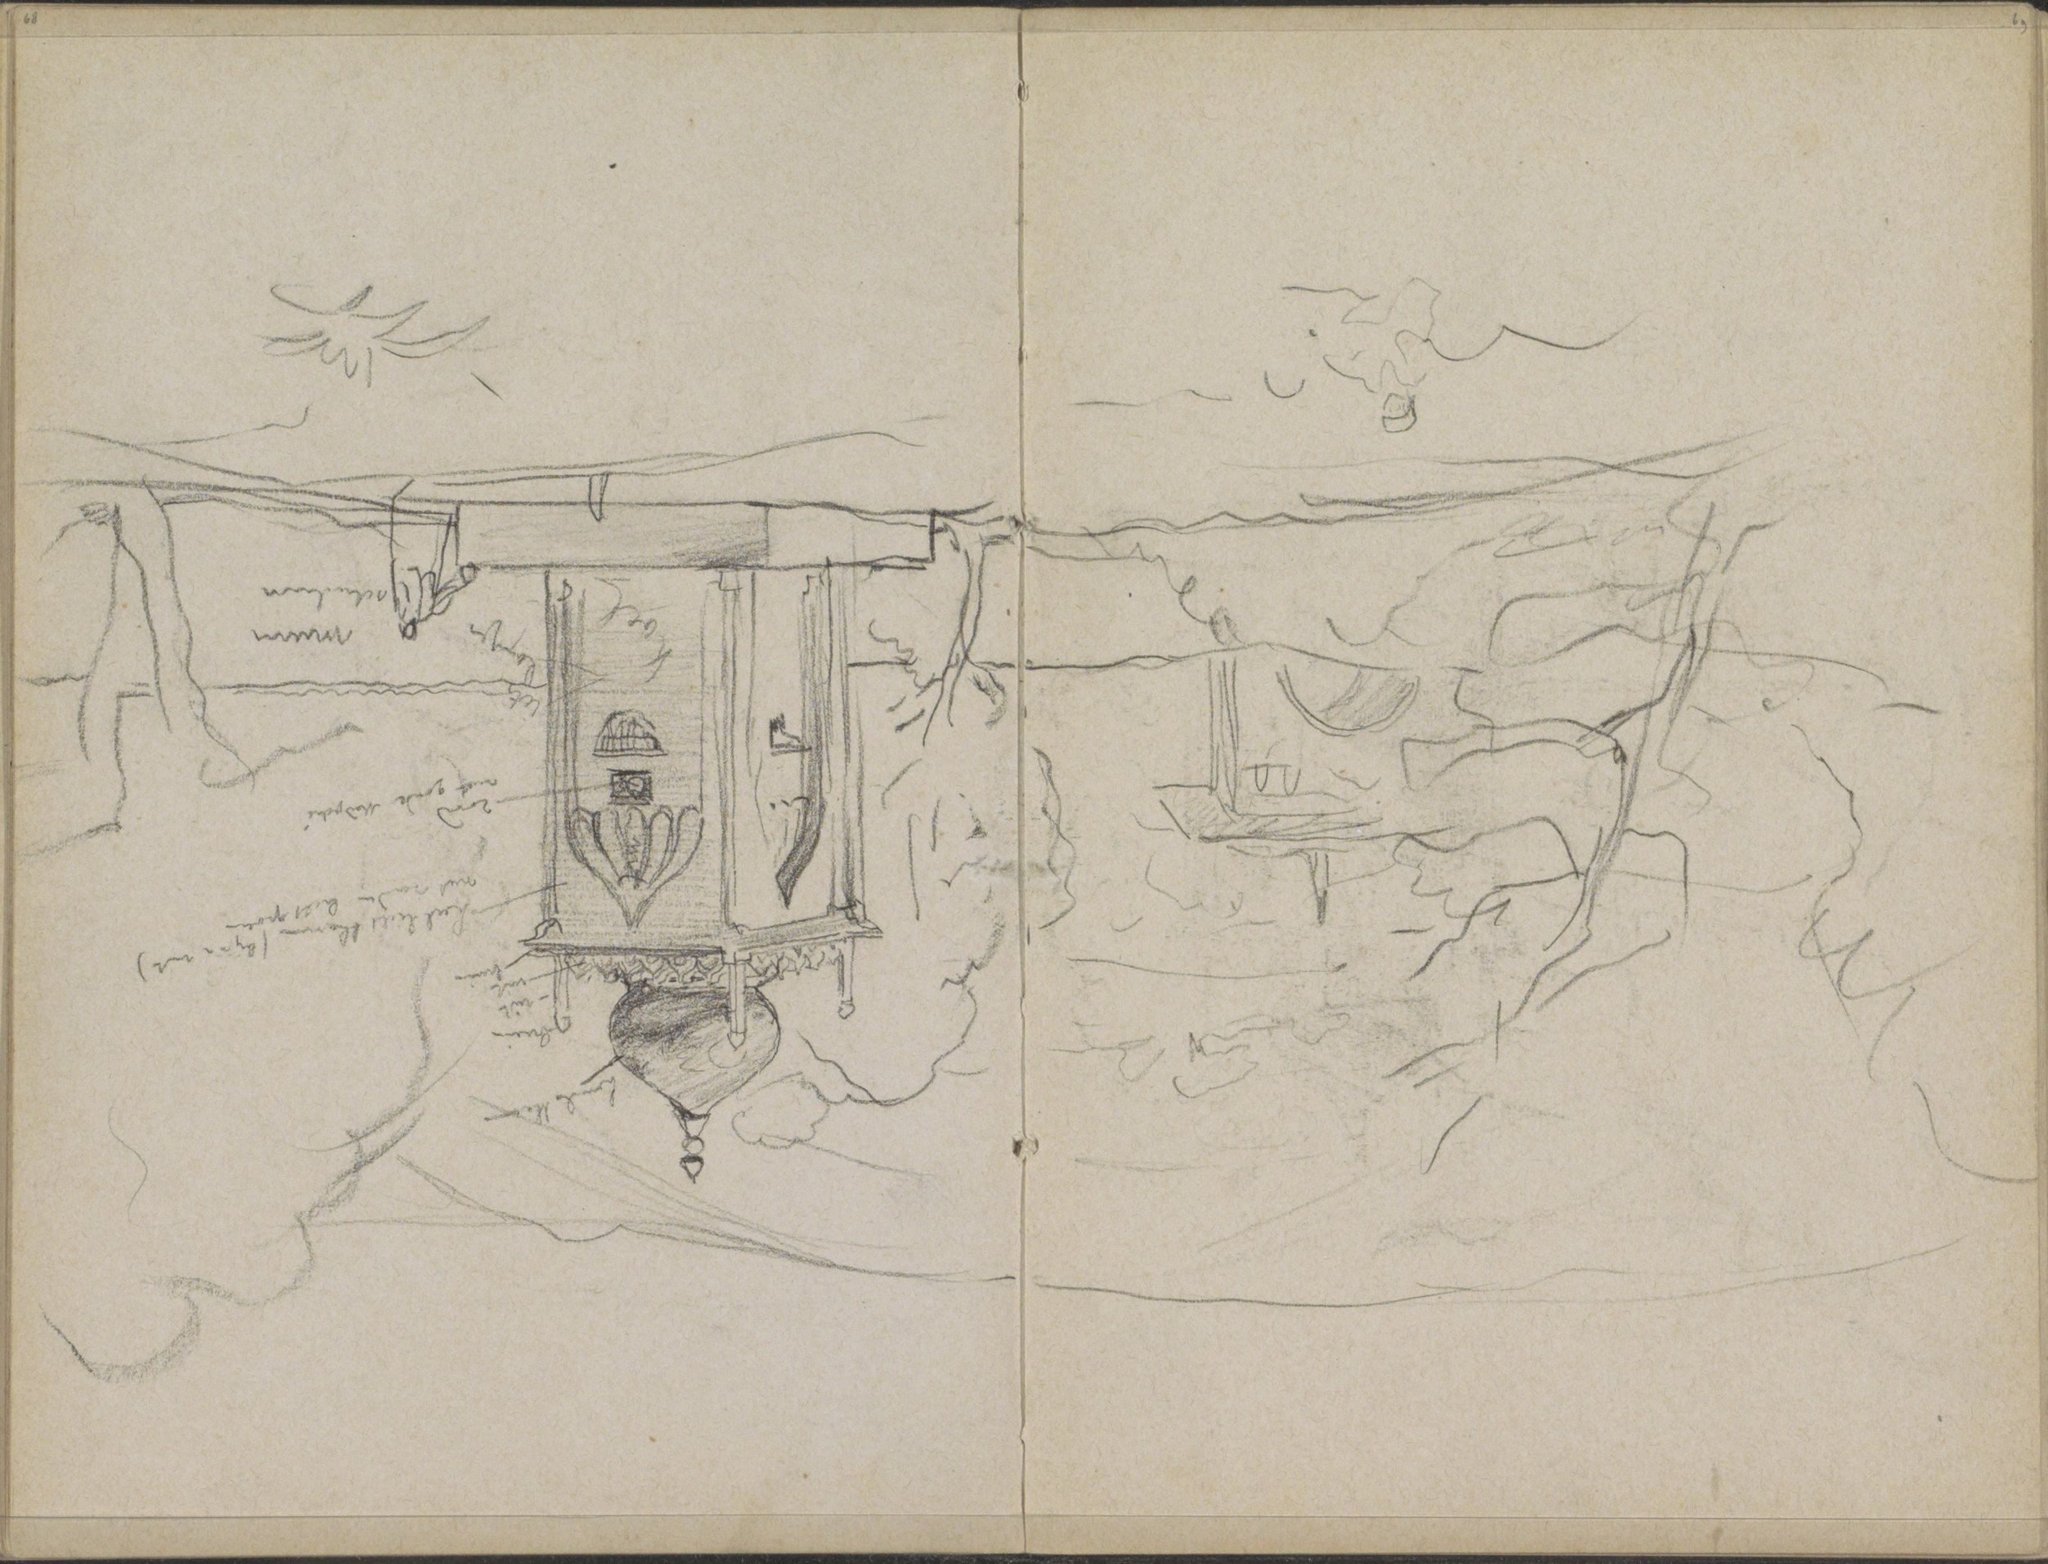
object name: sketchbook leaf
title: Landschap met een gebouw met een koepel, mogelijk een Russisch-orthodoxe kapel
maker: marius bauer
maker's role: draughtsman, print maker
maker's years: 1867-1932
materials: chalk, paper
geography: russia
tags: city-view, and landscape with man-made constructions, trees, church (exterior) - qq - small church, chapel, dome ~ architecture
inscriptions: kleurnotitie, handgeschreven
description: Pagina 68 en 69 uit een schetsboek met 54 bladen.